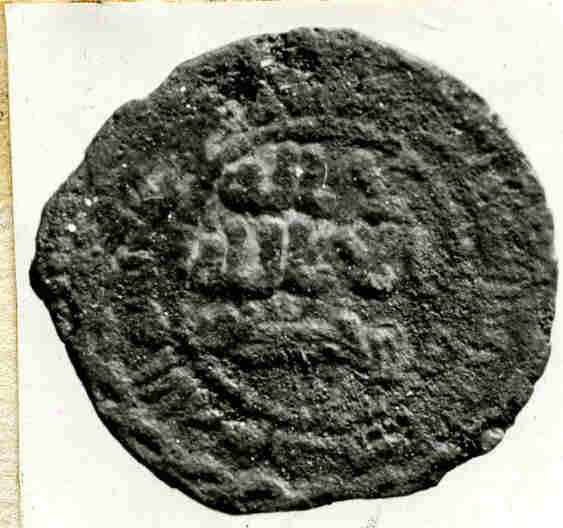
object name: coin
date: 758-768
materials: copper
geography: iran